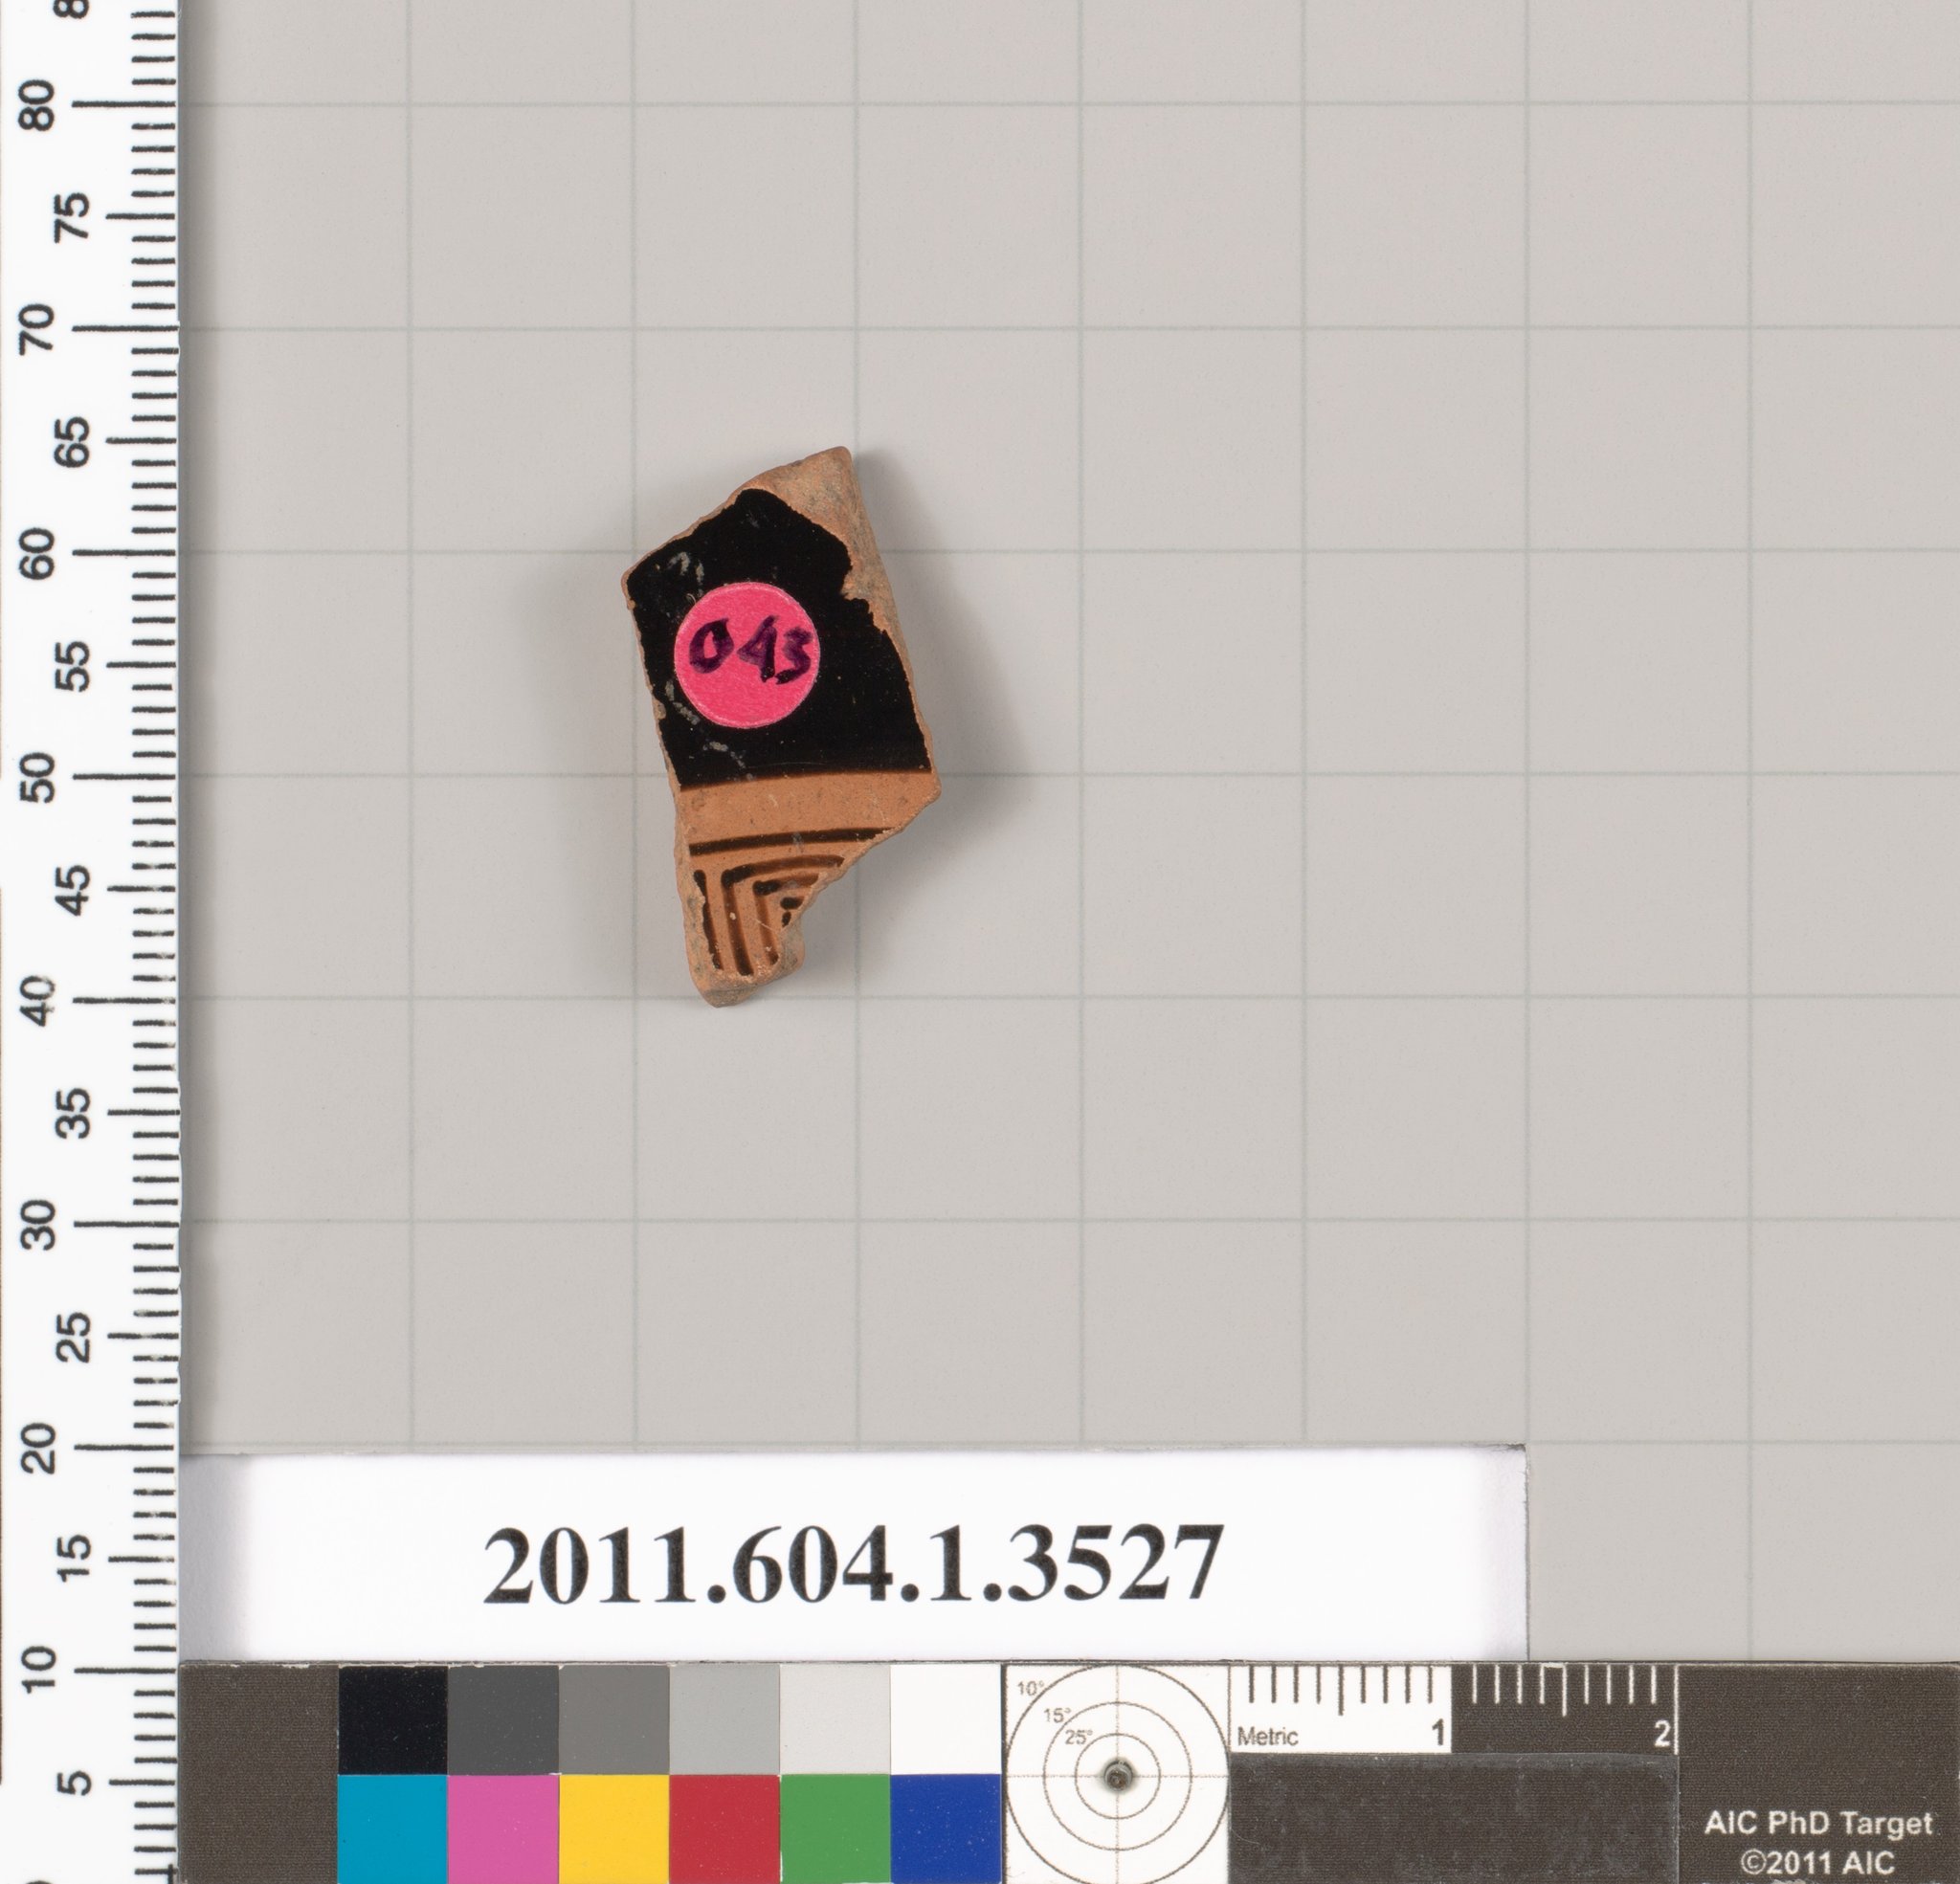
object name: kylix fragment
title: Terracotta fragment of a kylix (drinking cup)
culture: greek, attic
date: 475-451 BCE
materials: terracotta